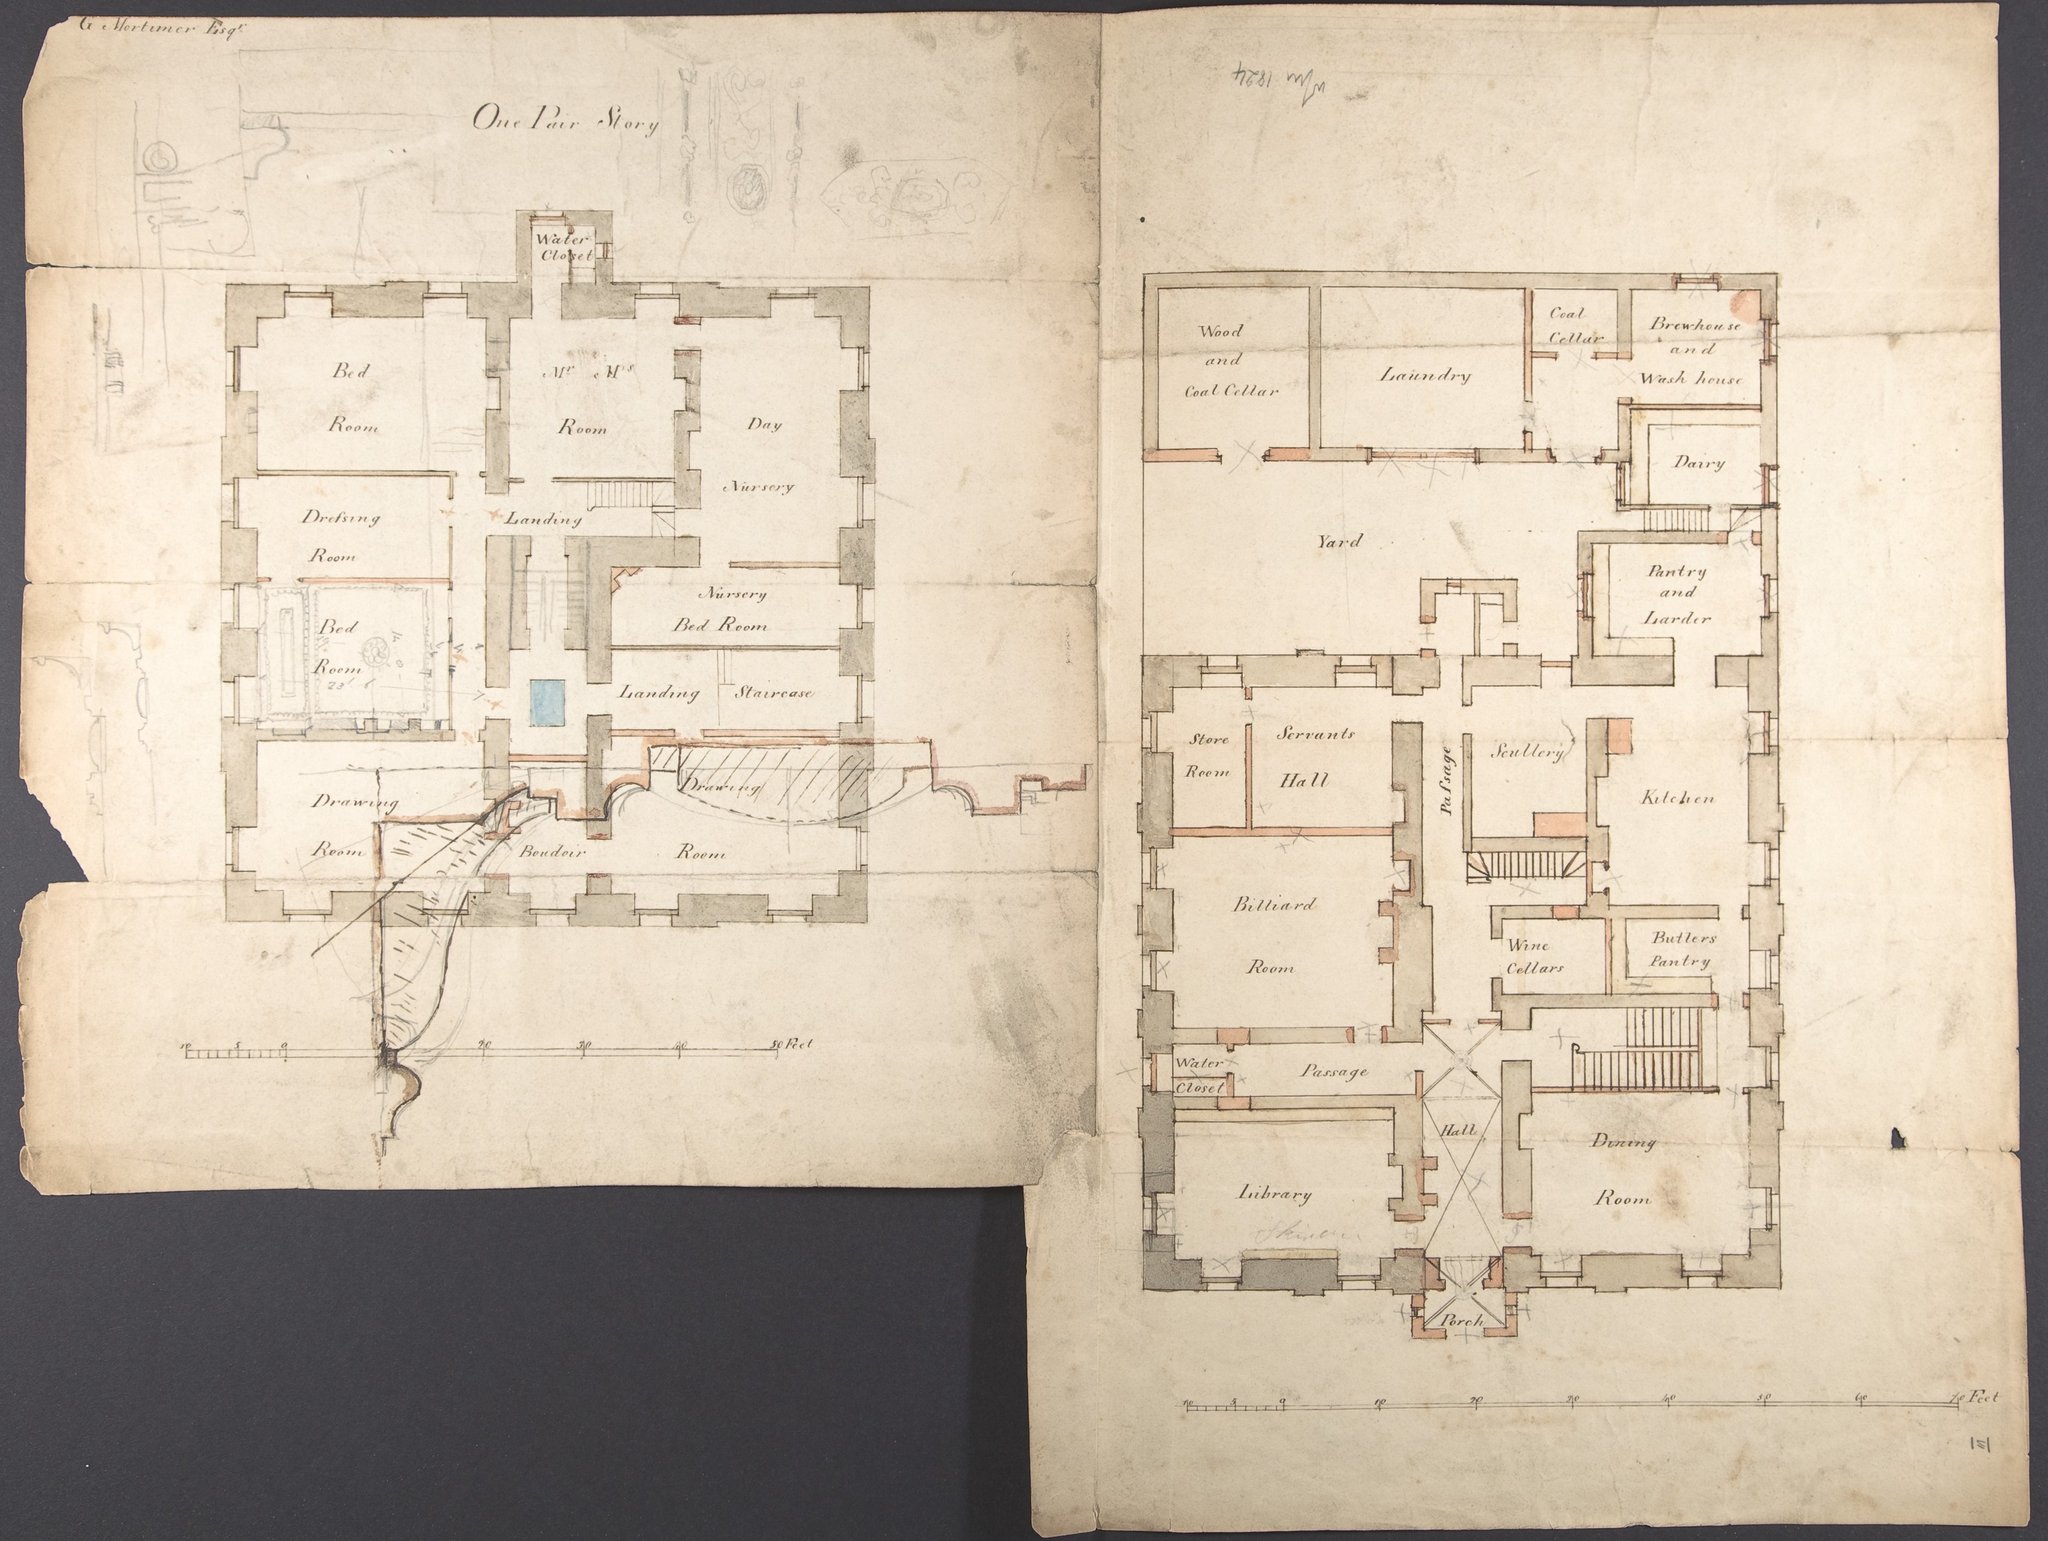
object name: drawing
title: Studies of the Pavilion at Fonthill, Wiltshire and Plans of the Ground and First Floors (recto); Studies for the Pavilion in Tudor-Gothic Style (verso)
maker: anonymous, british, 19th century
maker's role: artist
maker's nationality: british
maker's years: 1800-1900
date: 1824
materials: graphite, ink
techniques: brush, pen, wash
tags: architecture,houses